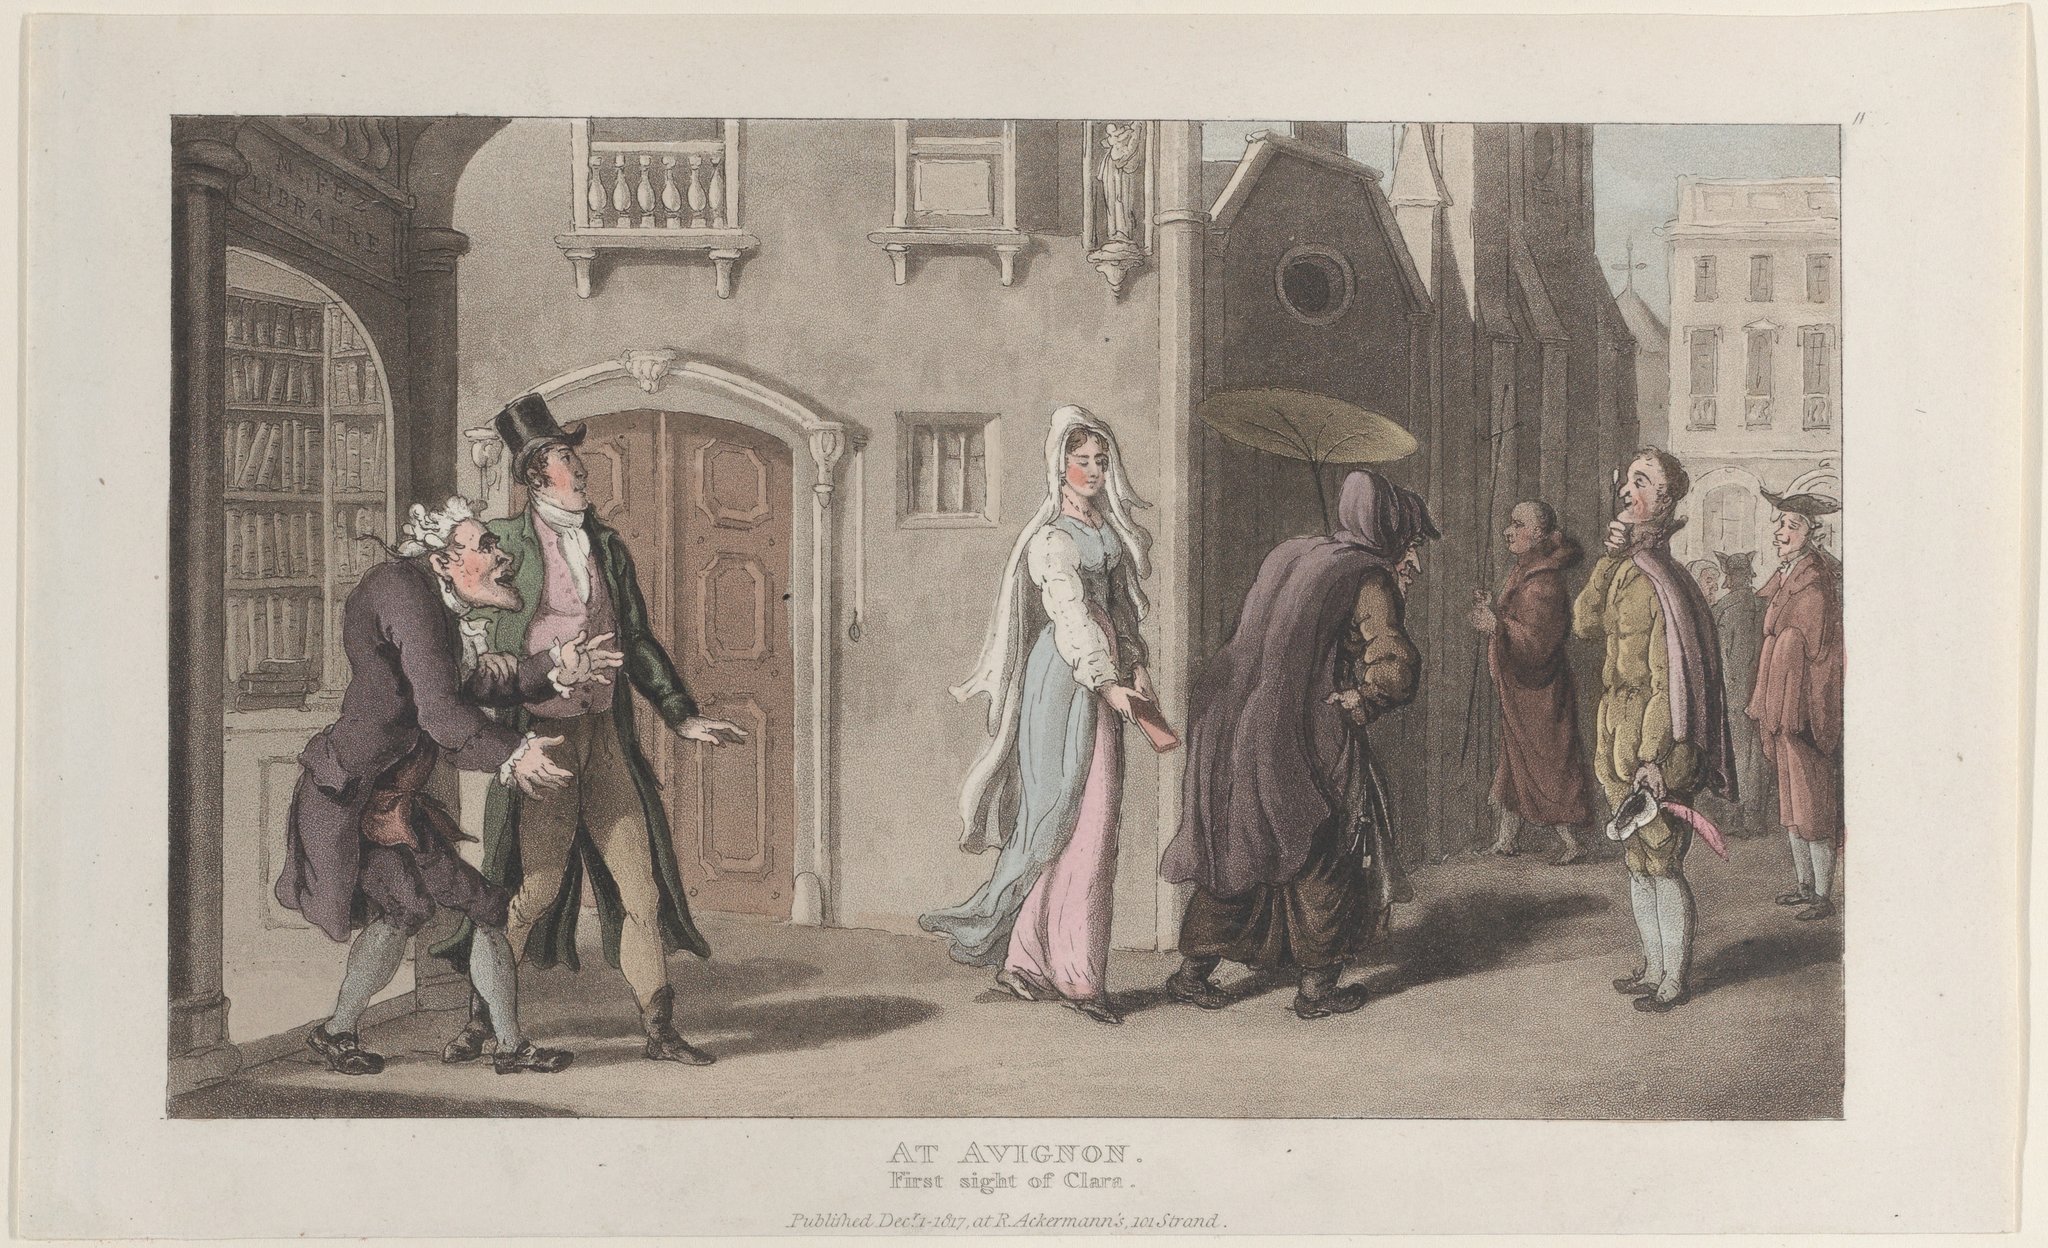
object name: print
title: At Avignon, First Sight of Clara, from "Journal of Sentimental Travels in the Southern Provinces of France, Shortly Before the Revolution"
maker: thomas rowlandson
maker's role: artist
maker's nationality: british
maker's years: 1757-1827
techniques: aquatint, etching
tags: men,women